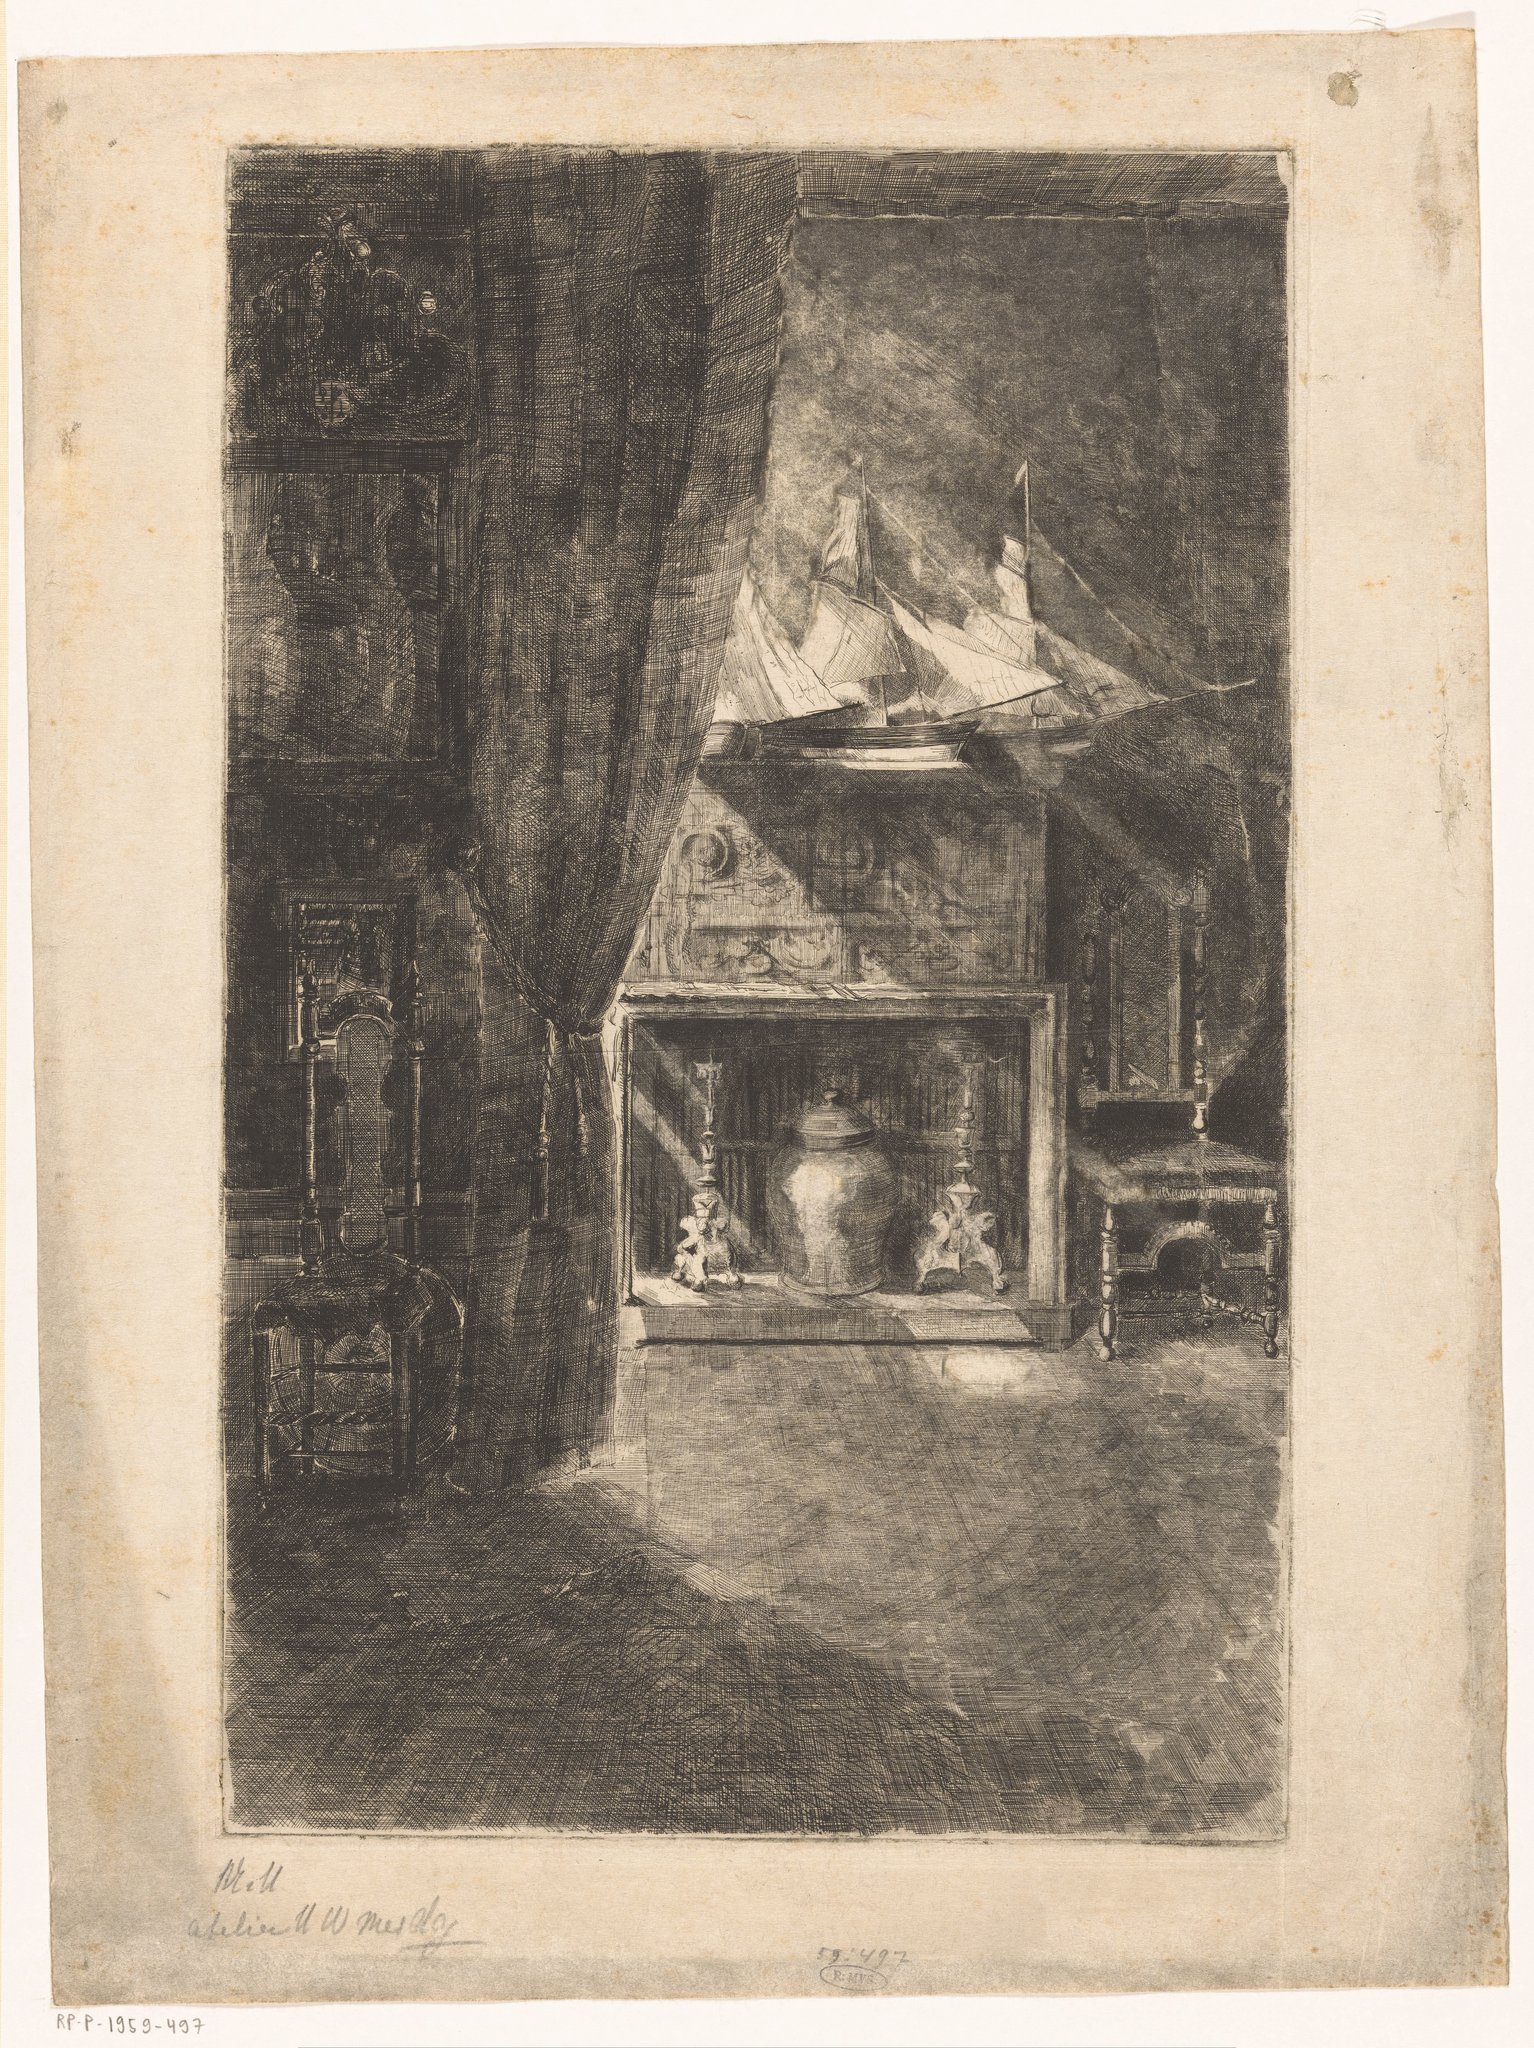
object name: print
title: Atelier van Hendrik Willem Mesdag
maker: barbara elisabeth van houten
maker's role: draughtsman, print maker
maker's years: 1862-1950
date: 1872-1950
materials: paper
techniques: etching, intaglio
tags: the hague, painter, print maker, draughtsman, hendrik willem mesdag, workshop, studio ~ painter, ship-model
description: Links een gordijn. Rechts op de achtergrond scheepsmodellen op een schouw.